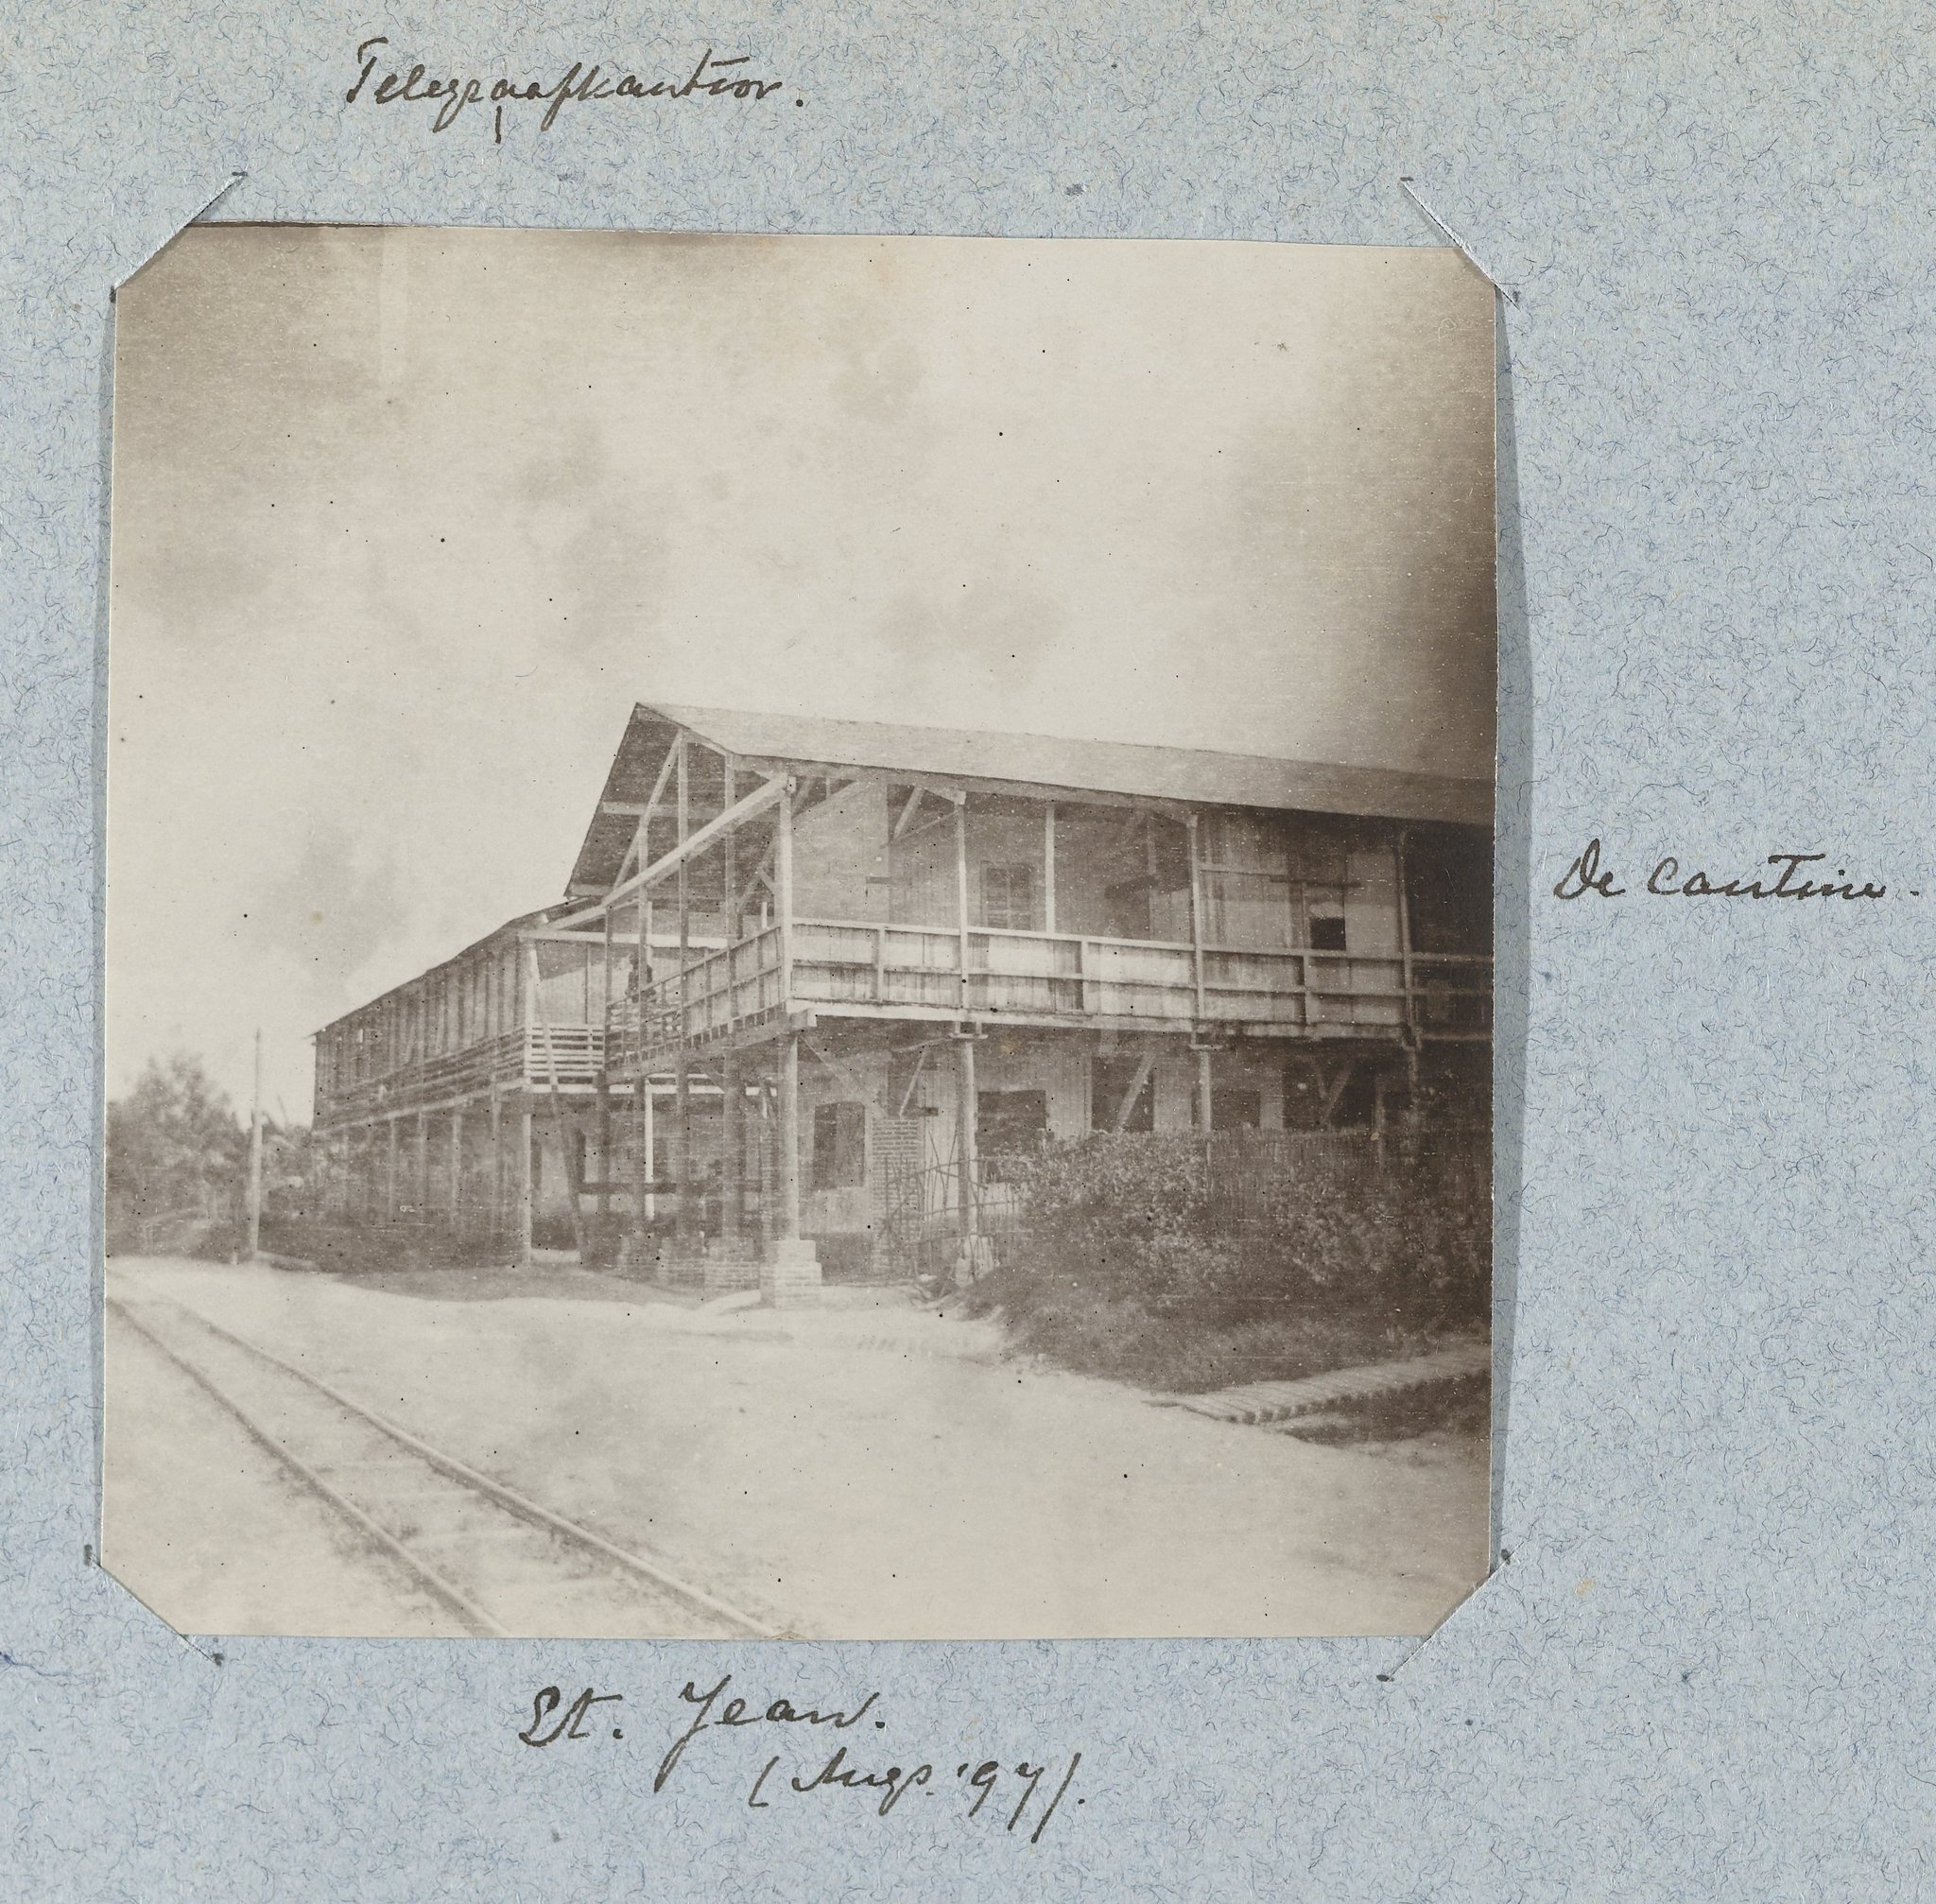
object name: photograph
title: St. Jean. (Augs. '97)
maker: théodore van lelyveld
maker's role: painter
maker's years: 1867-1954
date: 1808-1897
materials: photographic support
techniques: collodion silver print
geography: suriname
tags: workhouse, penal camp, penitentiary, chain gang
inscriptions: inscription: ‘St. Jean. (Augs. '97) / Telegraafkantoor / De cantine.’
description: Het telegraafkantoor en de kantine in de Franse strafkolonie te St. Jean (Saint-Jean-du-Maroni) in Guyana, augustus 1897. Fotoafdruk in een fotoalbum van Théodore van Lelyveld over Suriname uit 1895-1898.